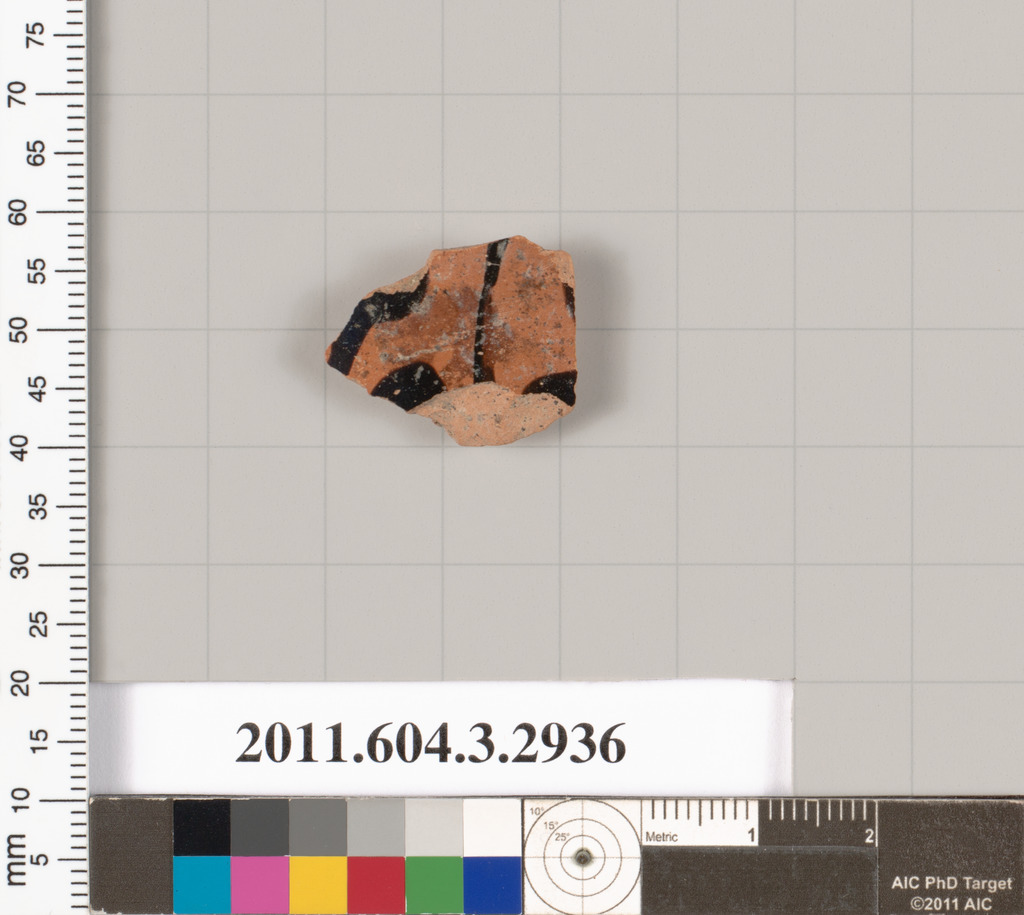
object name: undetermined open shape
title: Terracotta fragment of an open shape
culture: greek, attic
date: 600-401 BCE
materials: terracotta